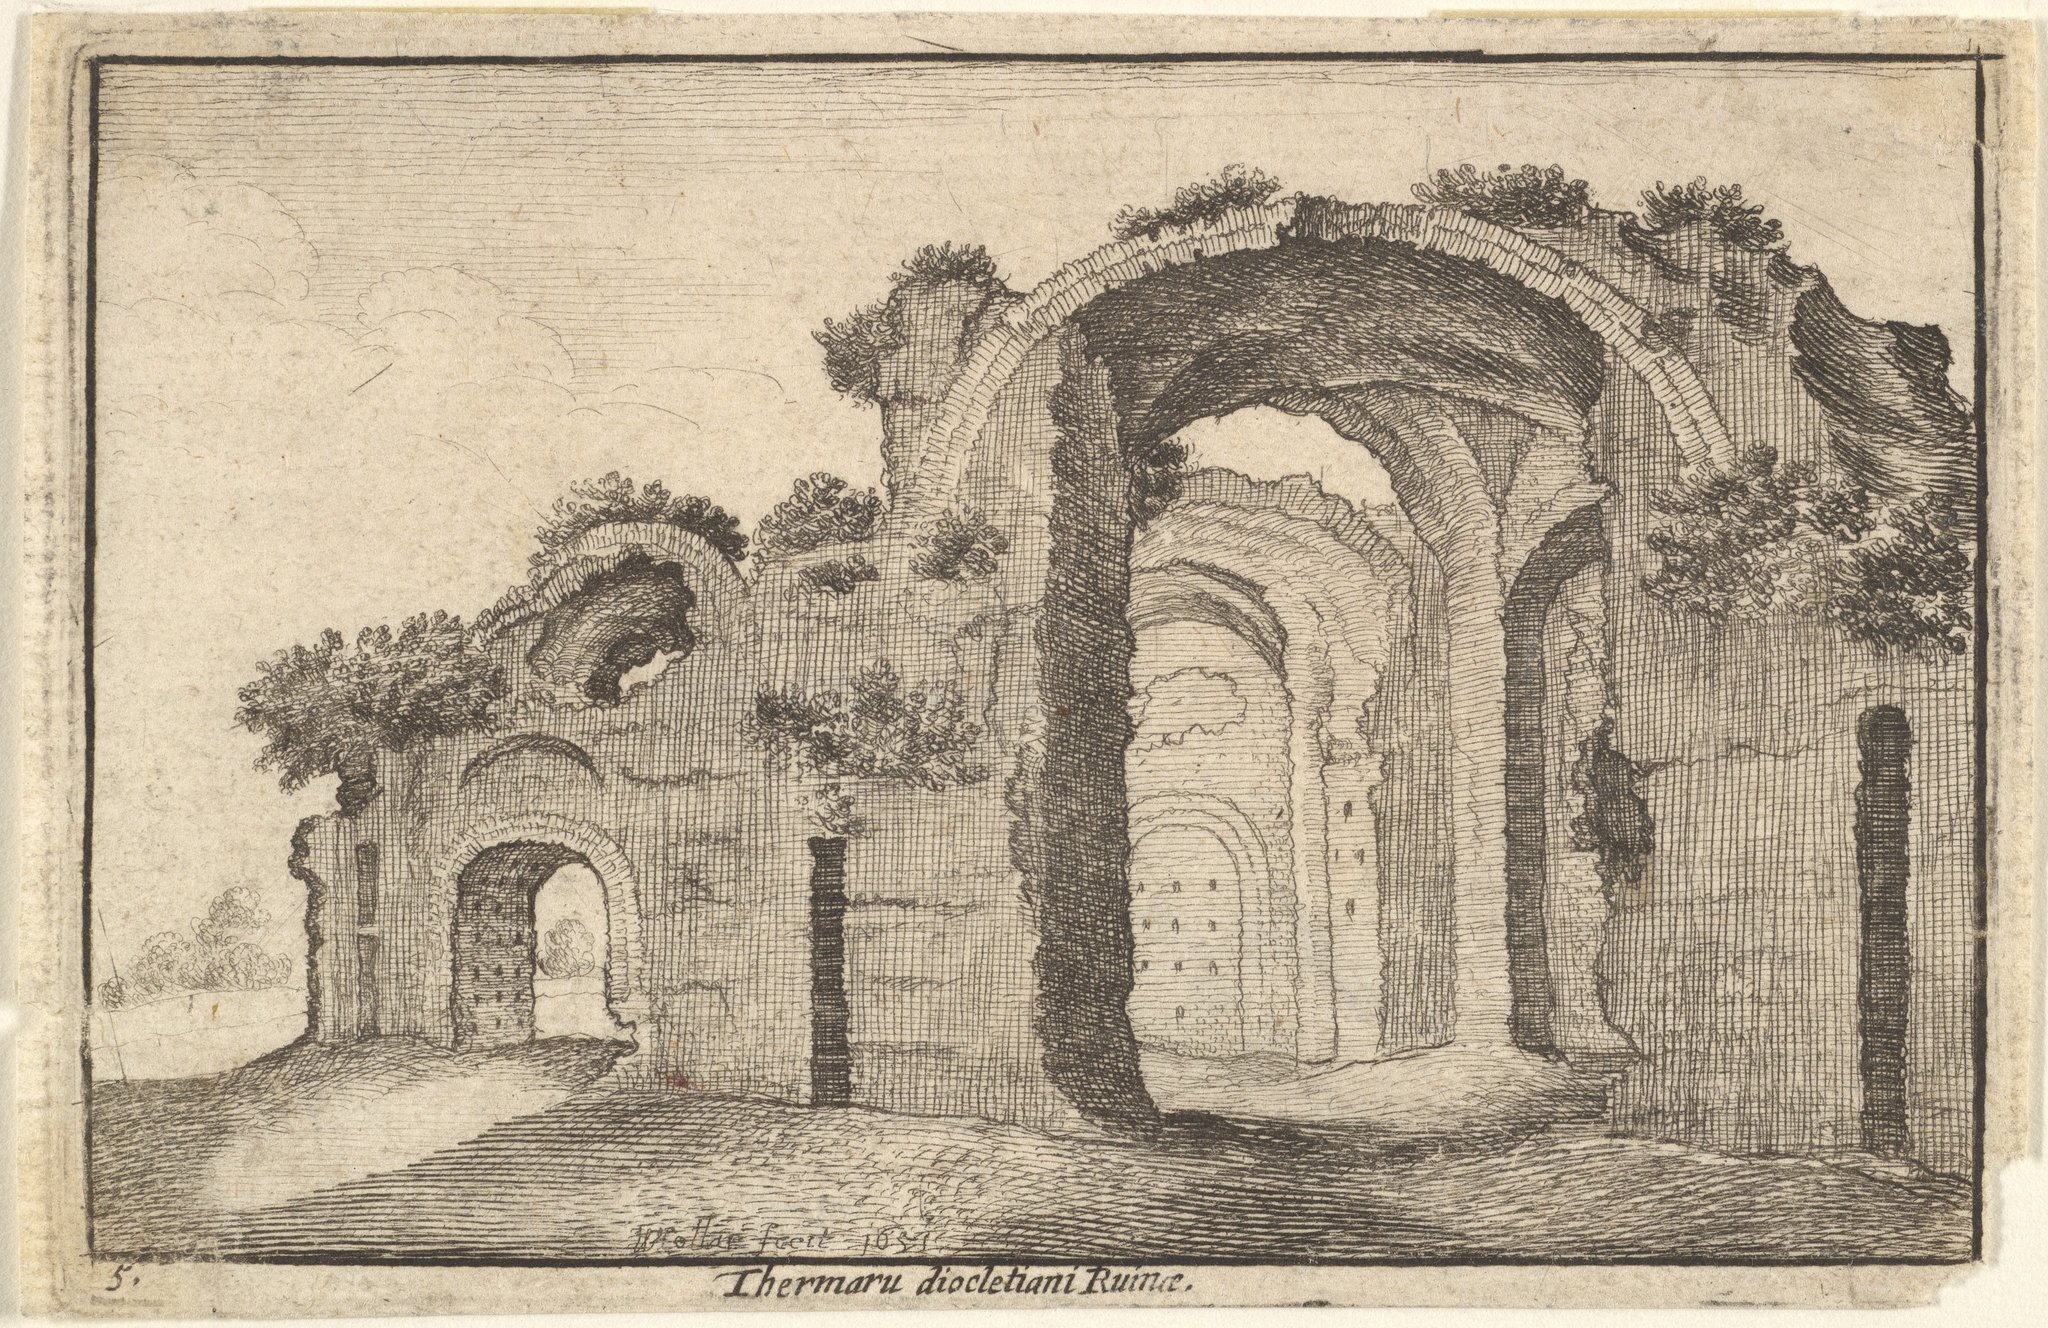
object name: print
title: Baths of Diocletian, Rome, from "Roman Ruins"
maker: wenceslaus hollar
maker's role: artist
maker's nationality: bohemian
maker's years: 1607-1677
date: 1601-1700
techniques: etching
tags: architecture